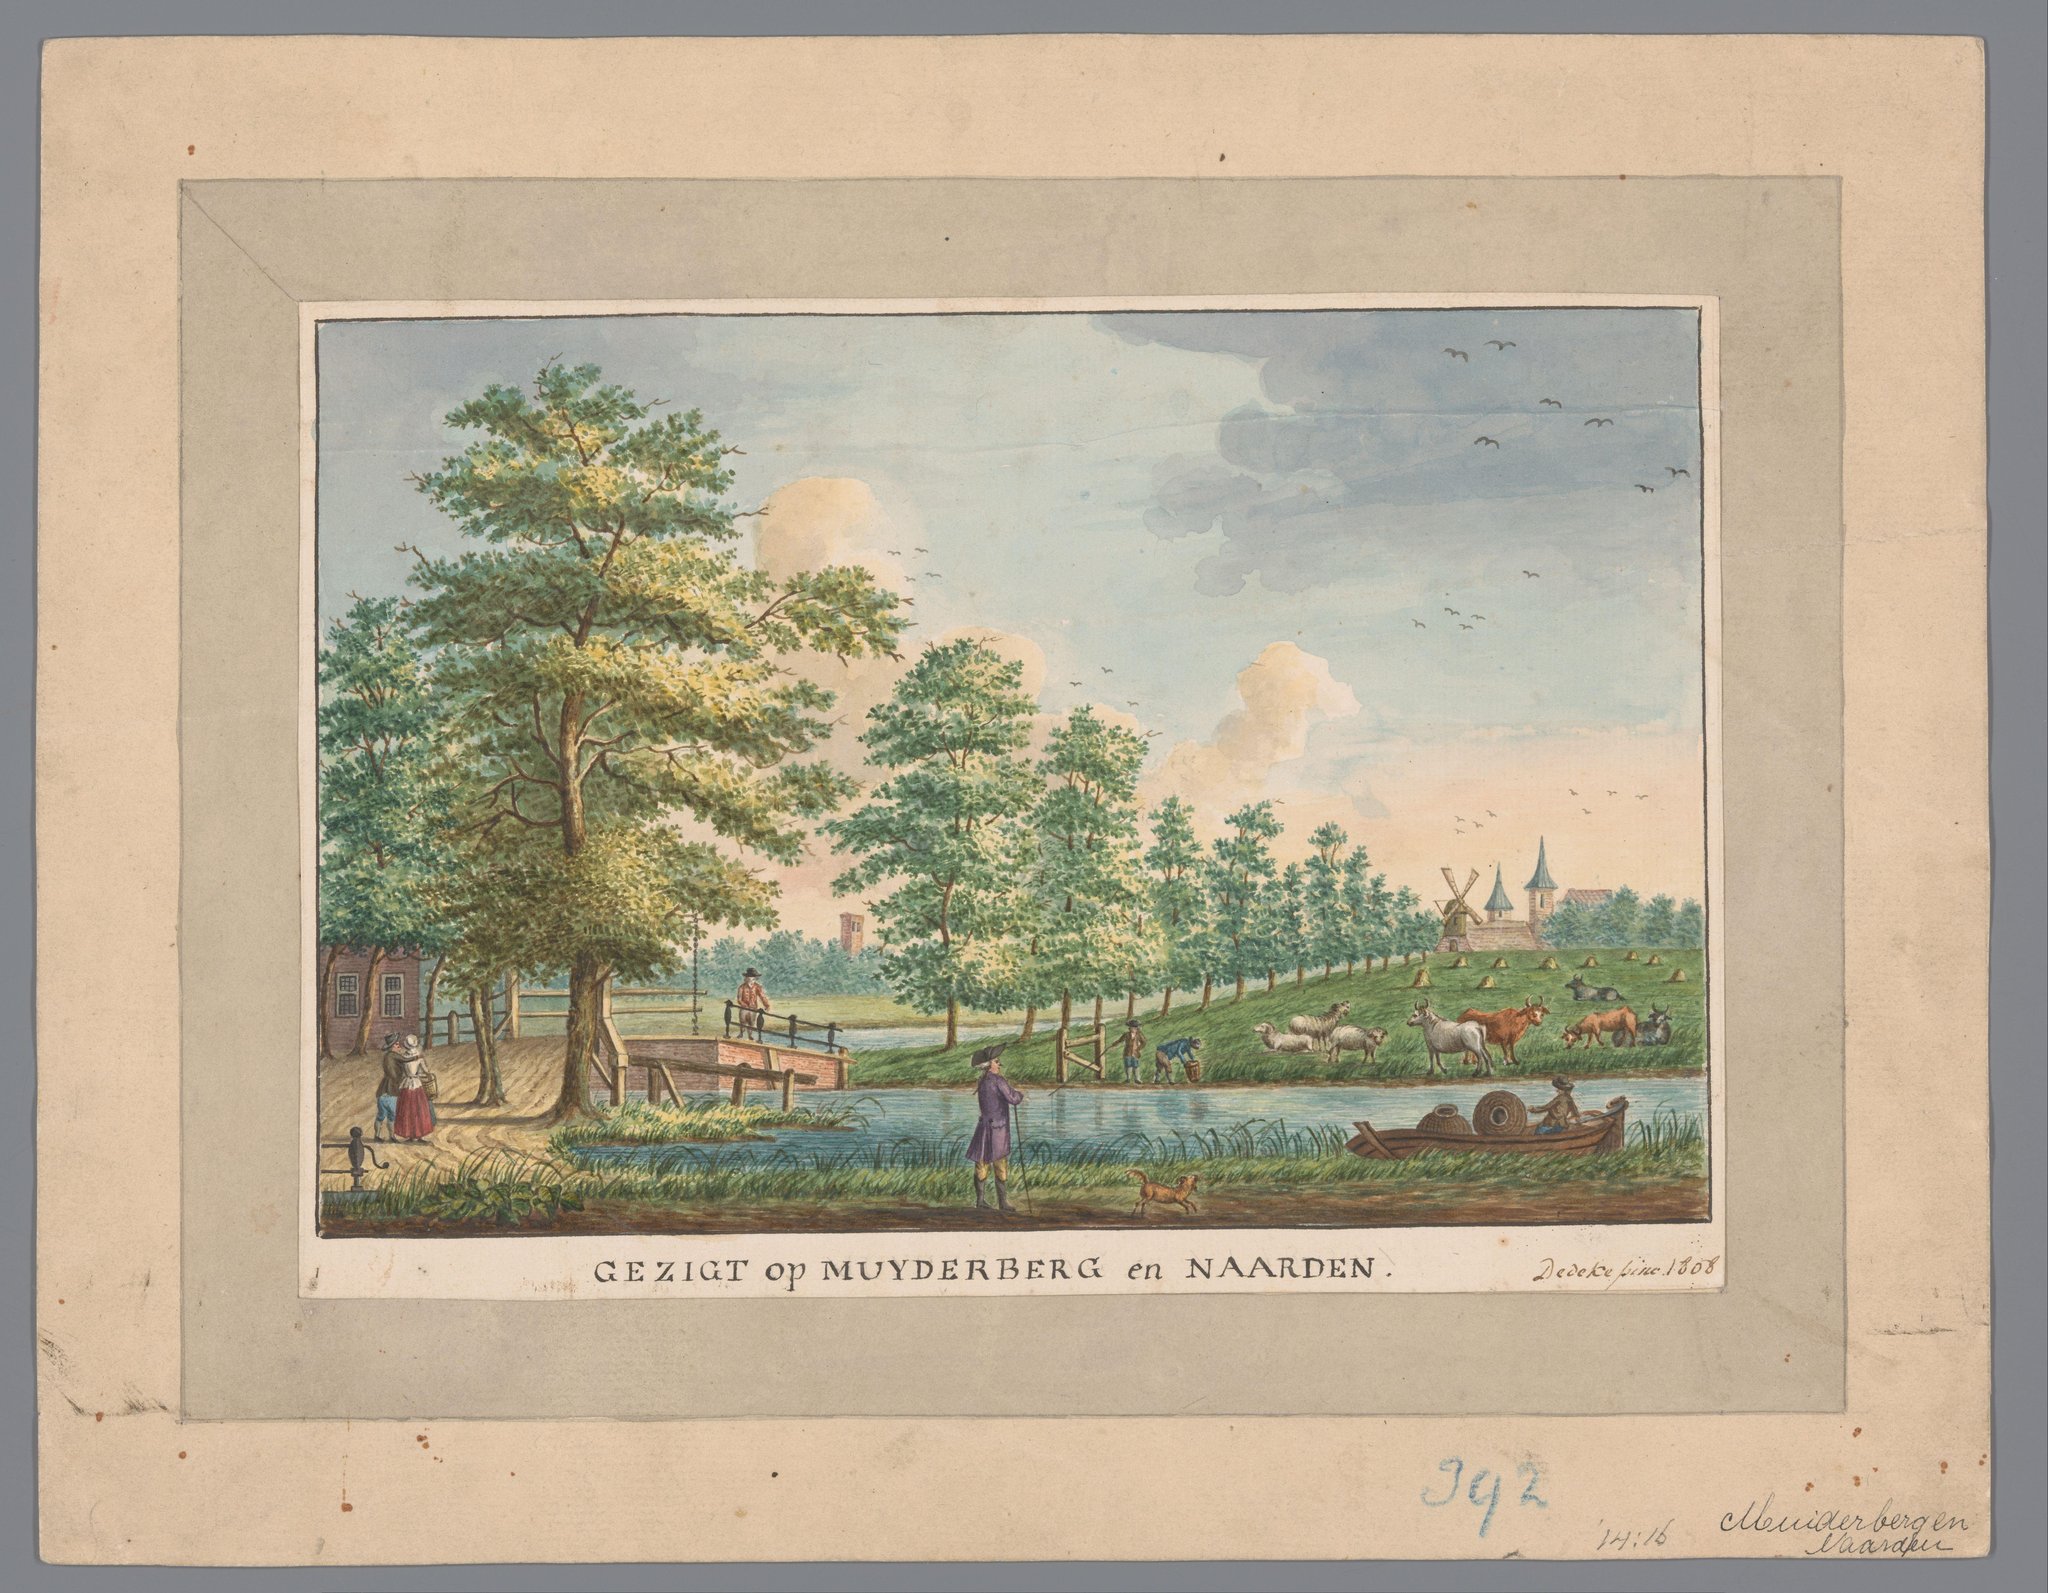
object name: drawing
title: Gezicht op Muyderberg en Naarden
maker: dedeke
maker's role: draughtsman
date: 1808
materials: paper, watercolor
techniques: brush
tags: city-view, and landscape with man-made constructions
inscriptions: collector's mark: Lugt 2228, inscription: ‘Dedeke pinx 1808’